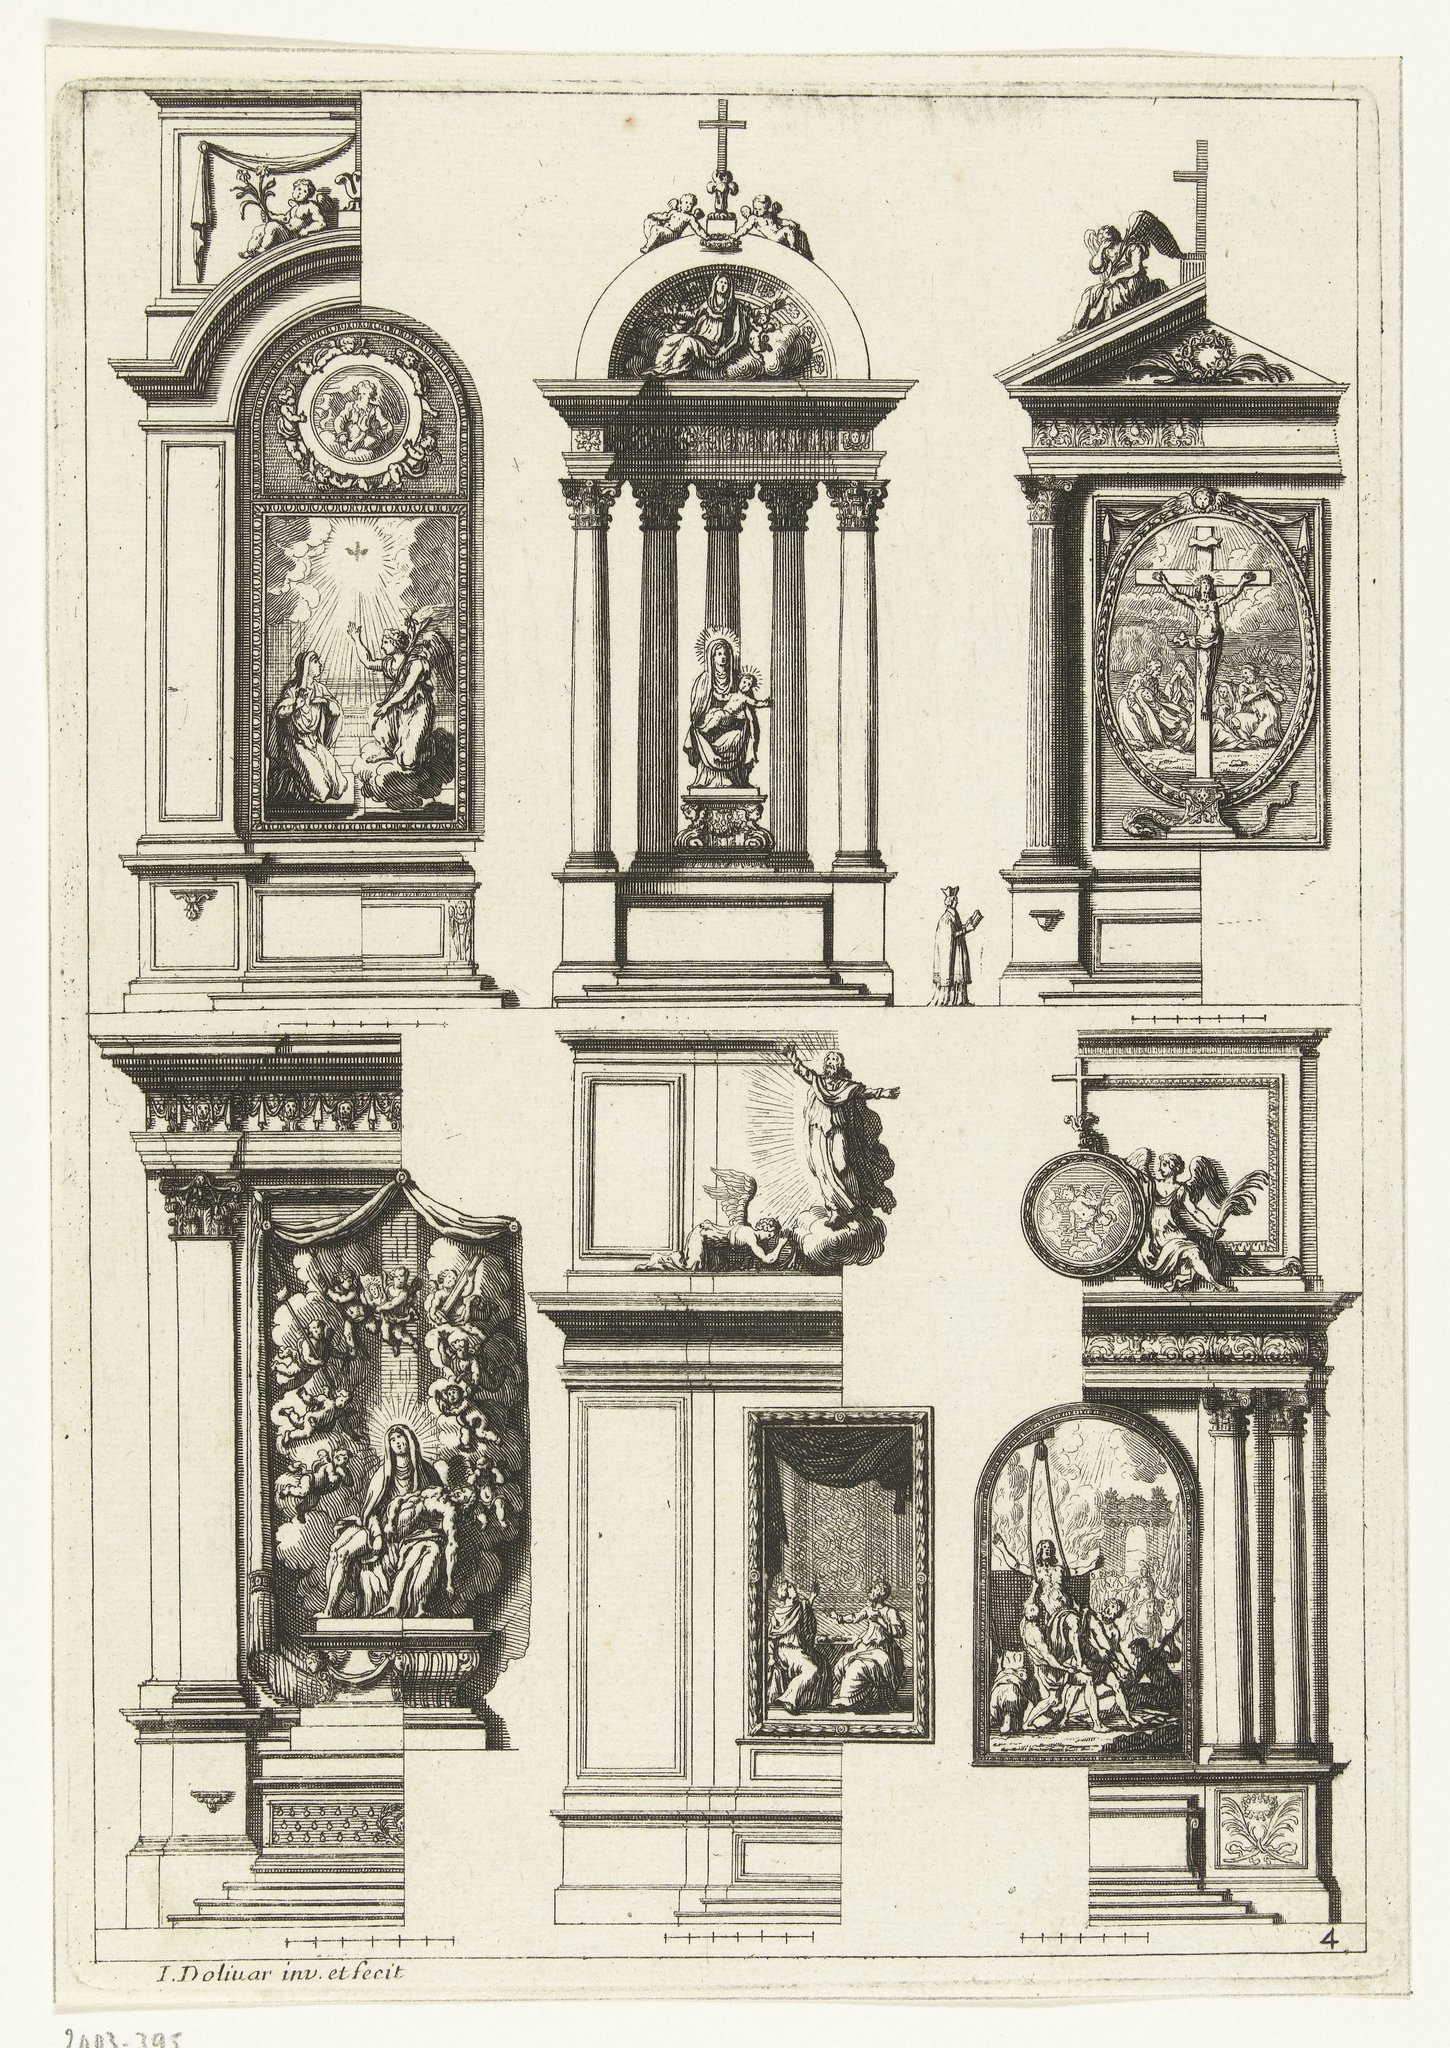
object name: ornament print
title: Nouveau Livre d'Autel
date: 1690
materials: paper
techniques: etching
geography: france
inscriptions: number: ‘4’, signature: ‘I. Dolivar inv. et fecit’